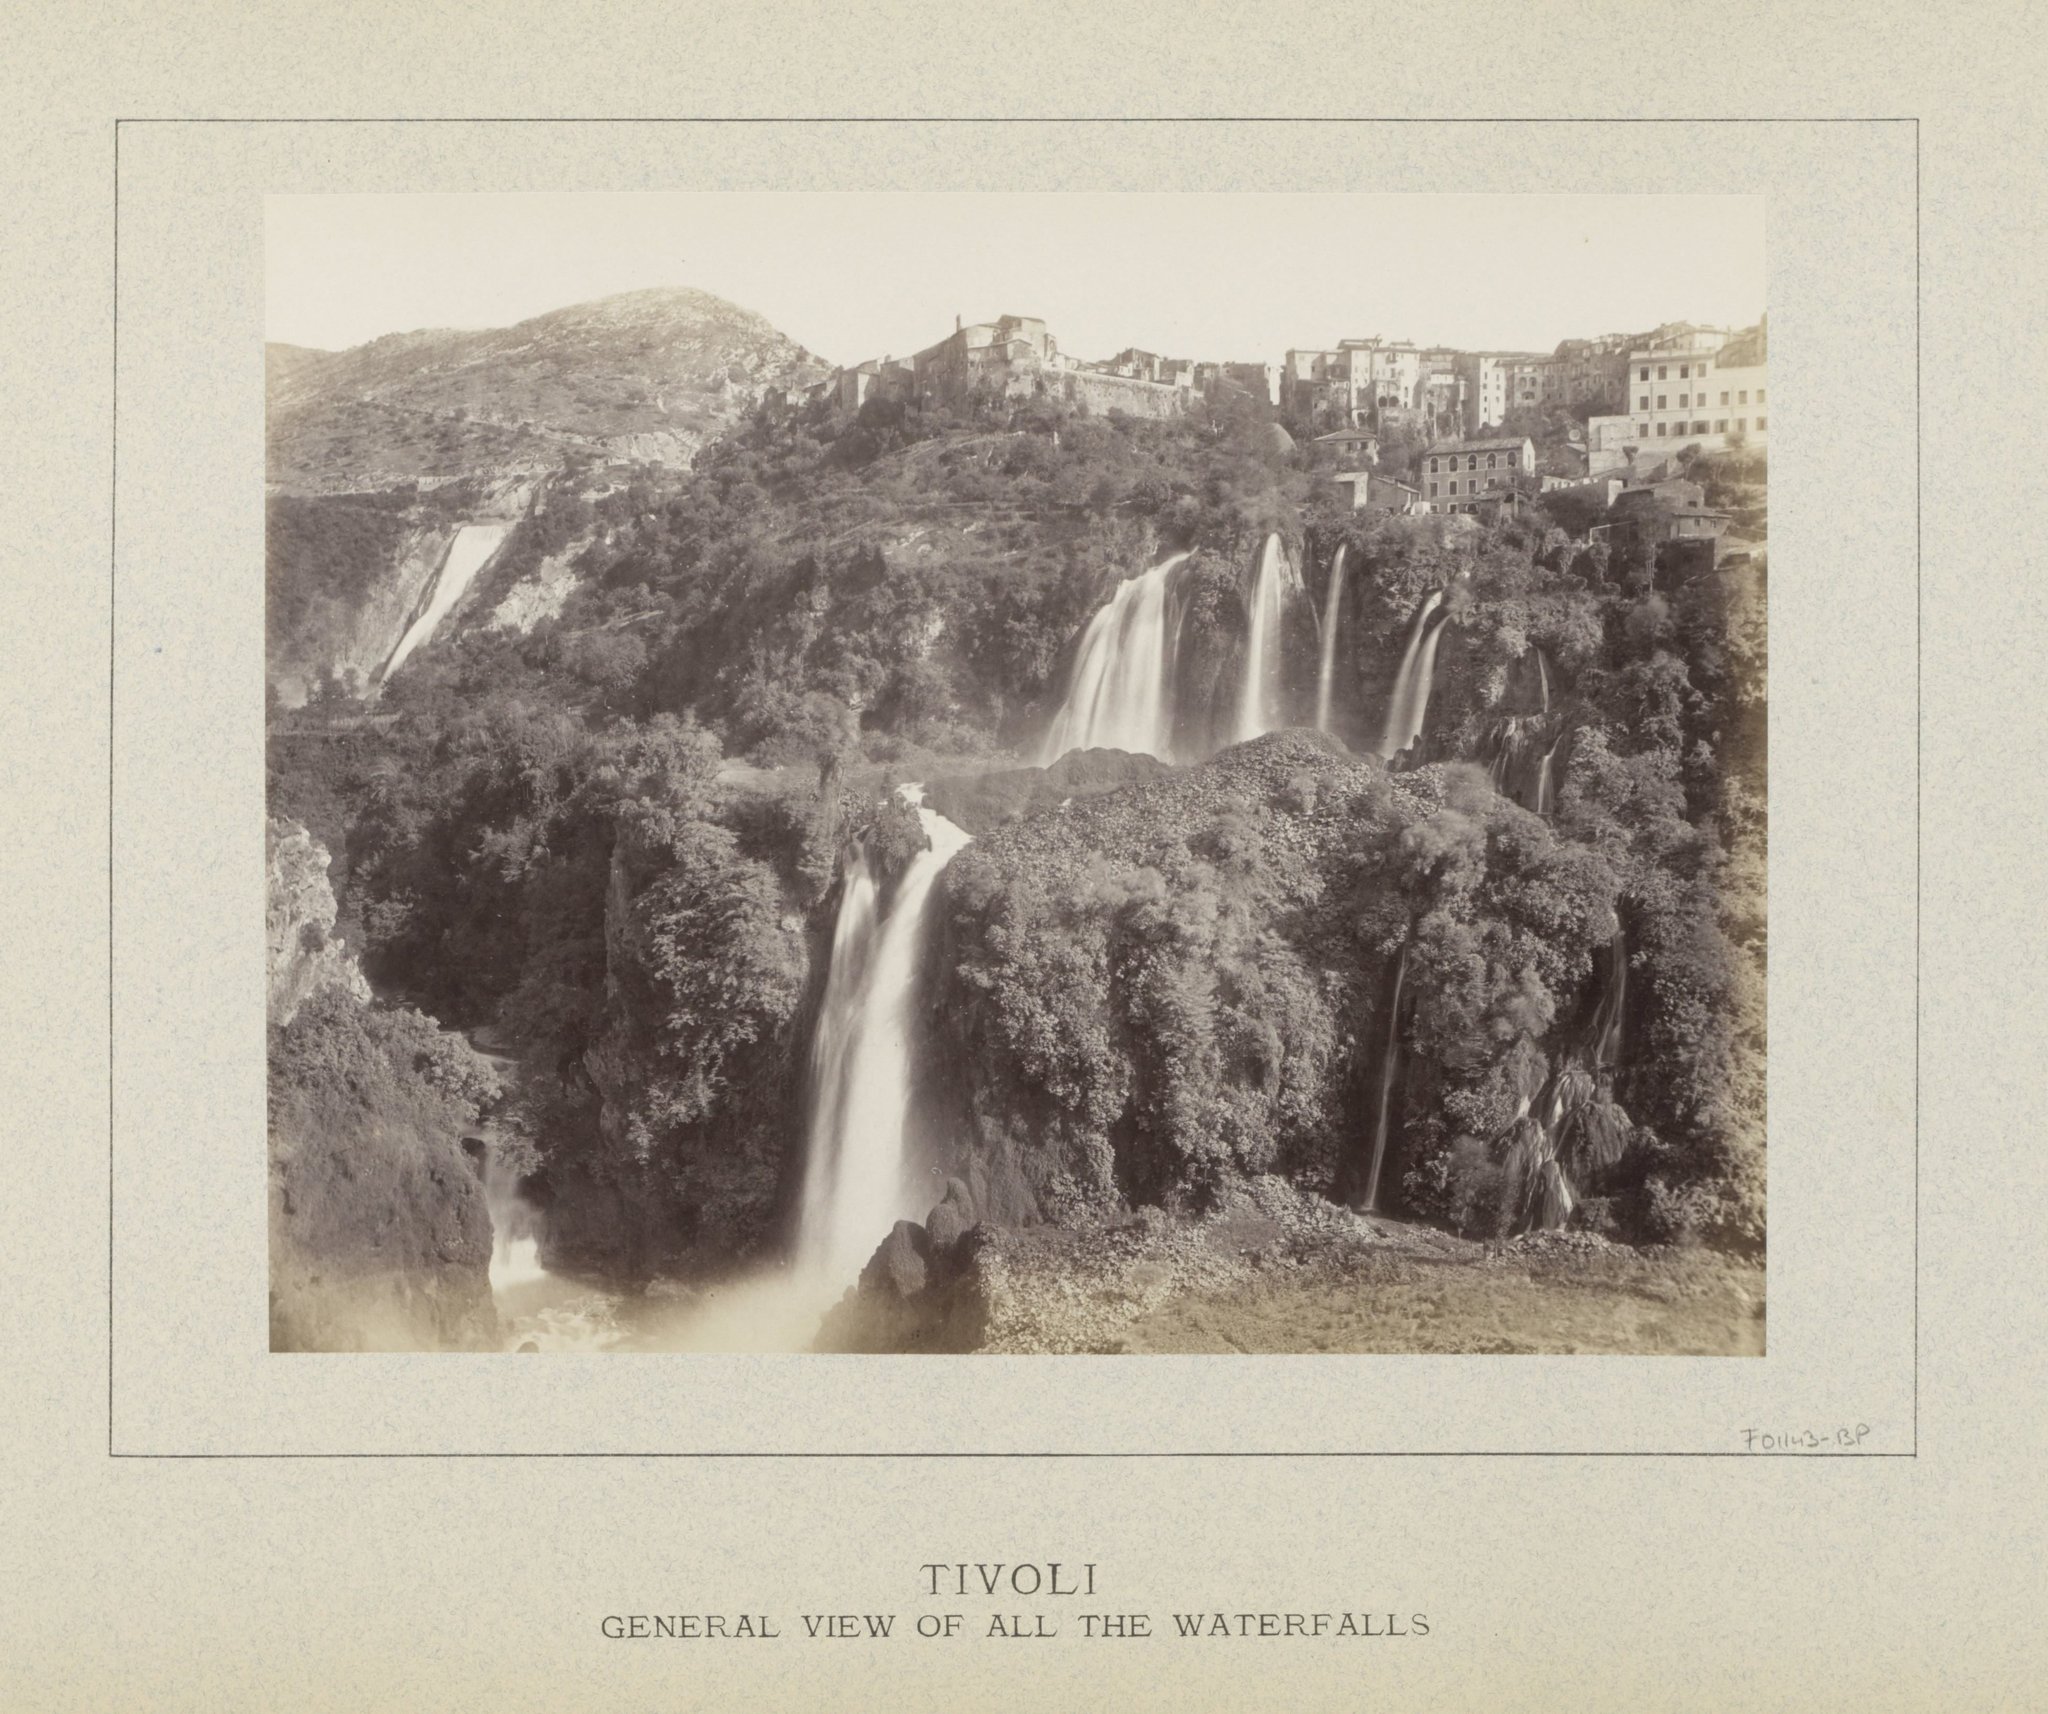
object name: photograph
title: Tivoli, general view of all the waterfalls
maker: Anonymous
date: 1860-1900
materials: photographic support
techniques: albumen print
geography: tivoli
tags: waterfall (+ landscape with figures, staffage), tivoli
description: Onderdeel van Fotoalbum met opnames van bezienswaardigheden en kunstwerken in Rome.